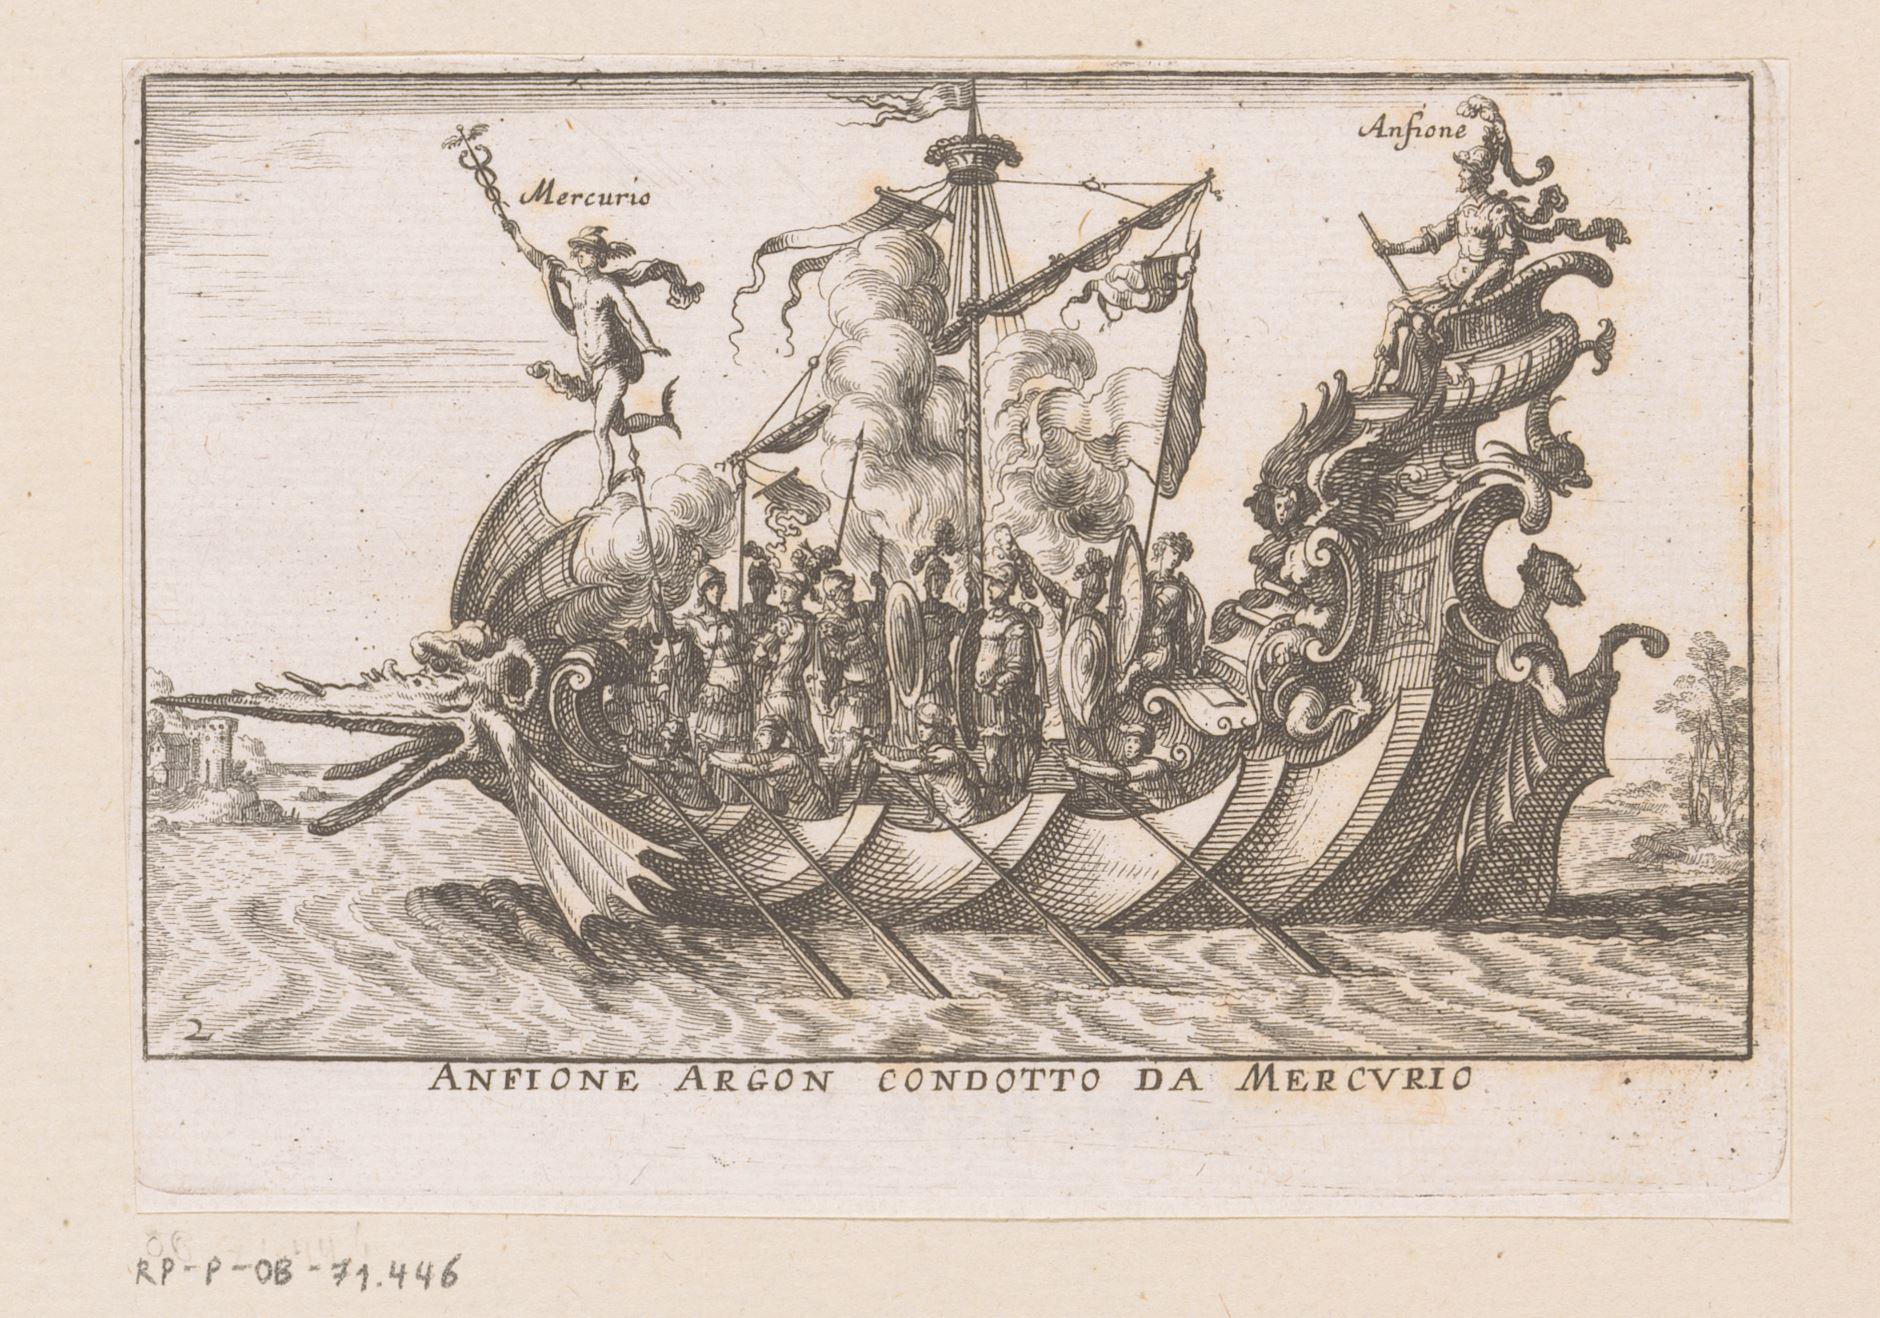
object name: print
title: Schip met Mercurius en Amphion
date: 1635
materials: paper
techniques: etching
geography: paris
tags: (story of) mercury (hermes), ships (in general), (story of) amphion and zethus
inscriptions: collector's mark: Lugt 240